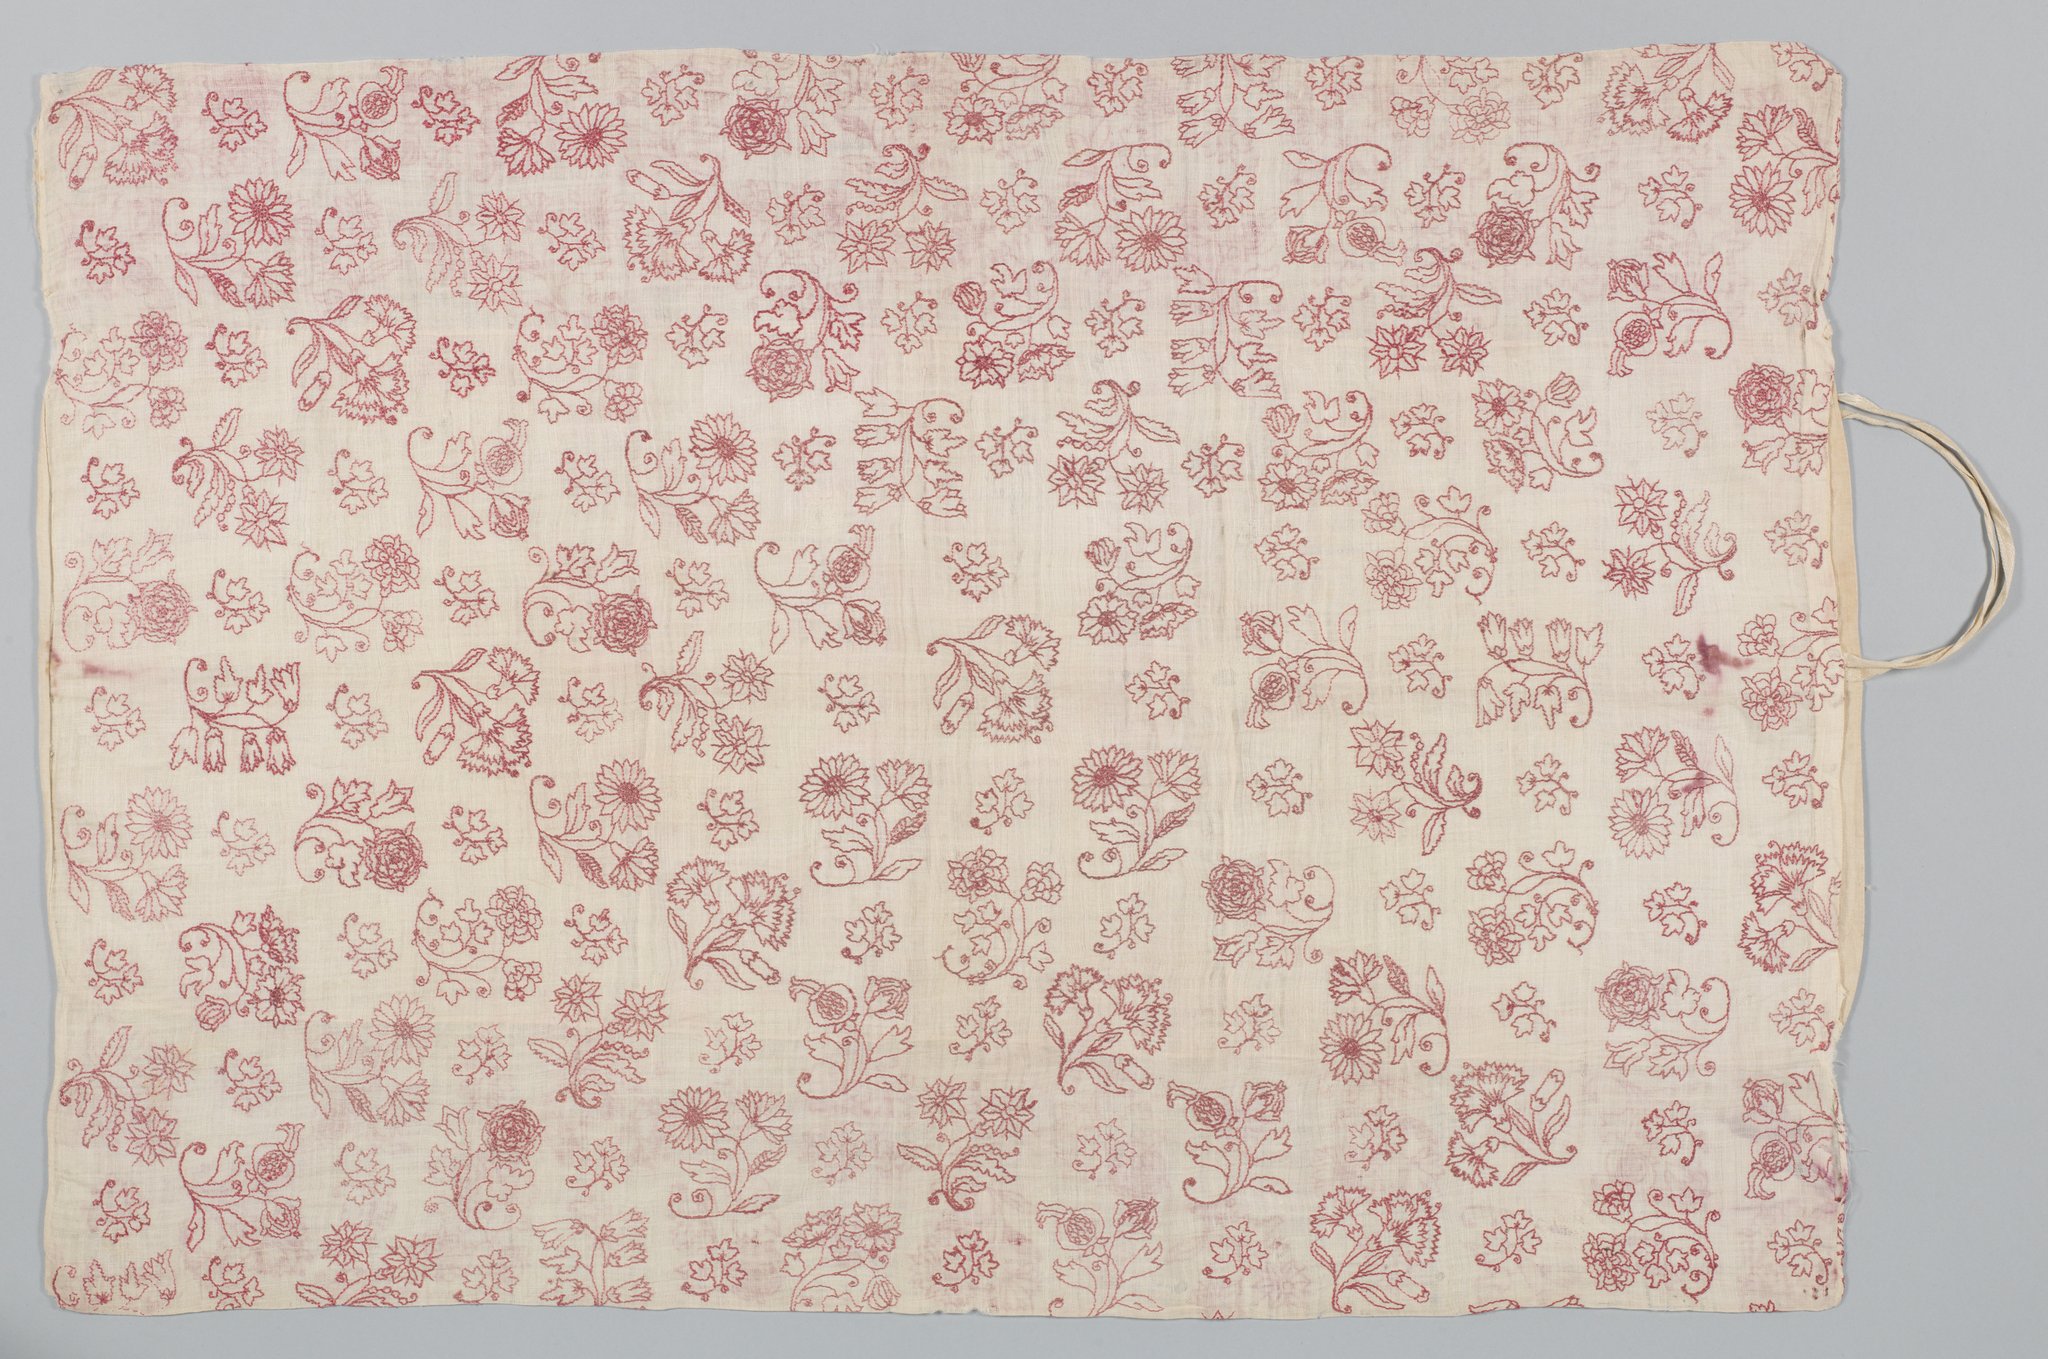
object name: pillowcase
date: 1601-1633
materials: linen, silk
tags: flowers